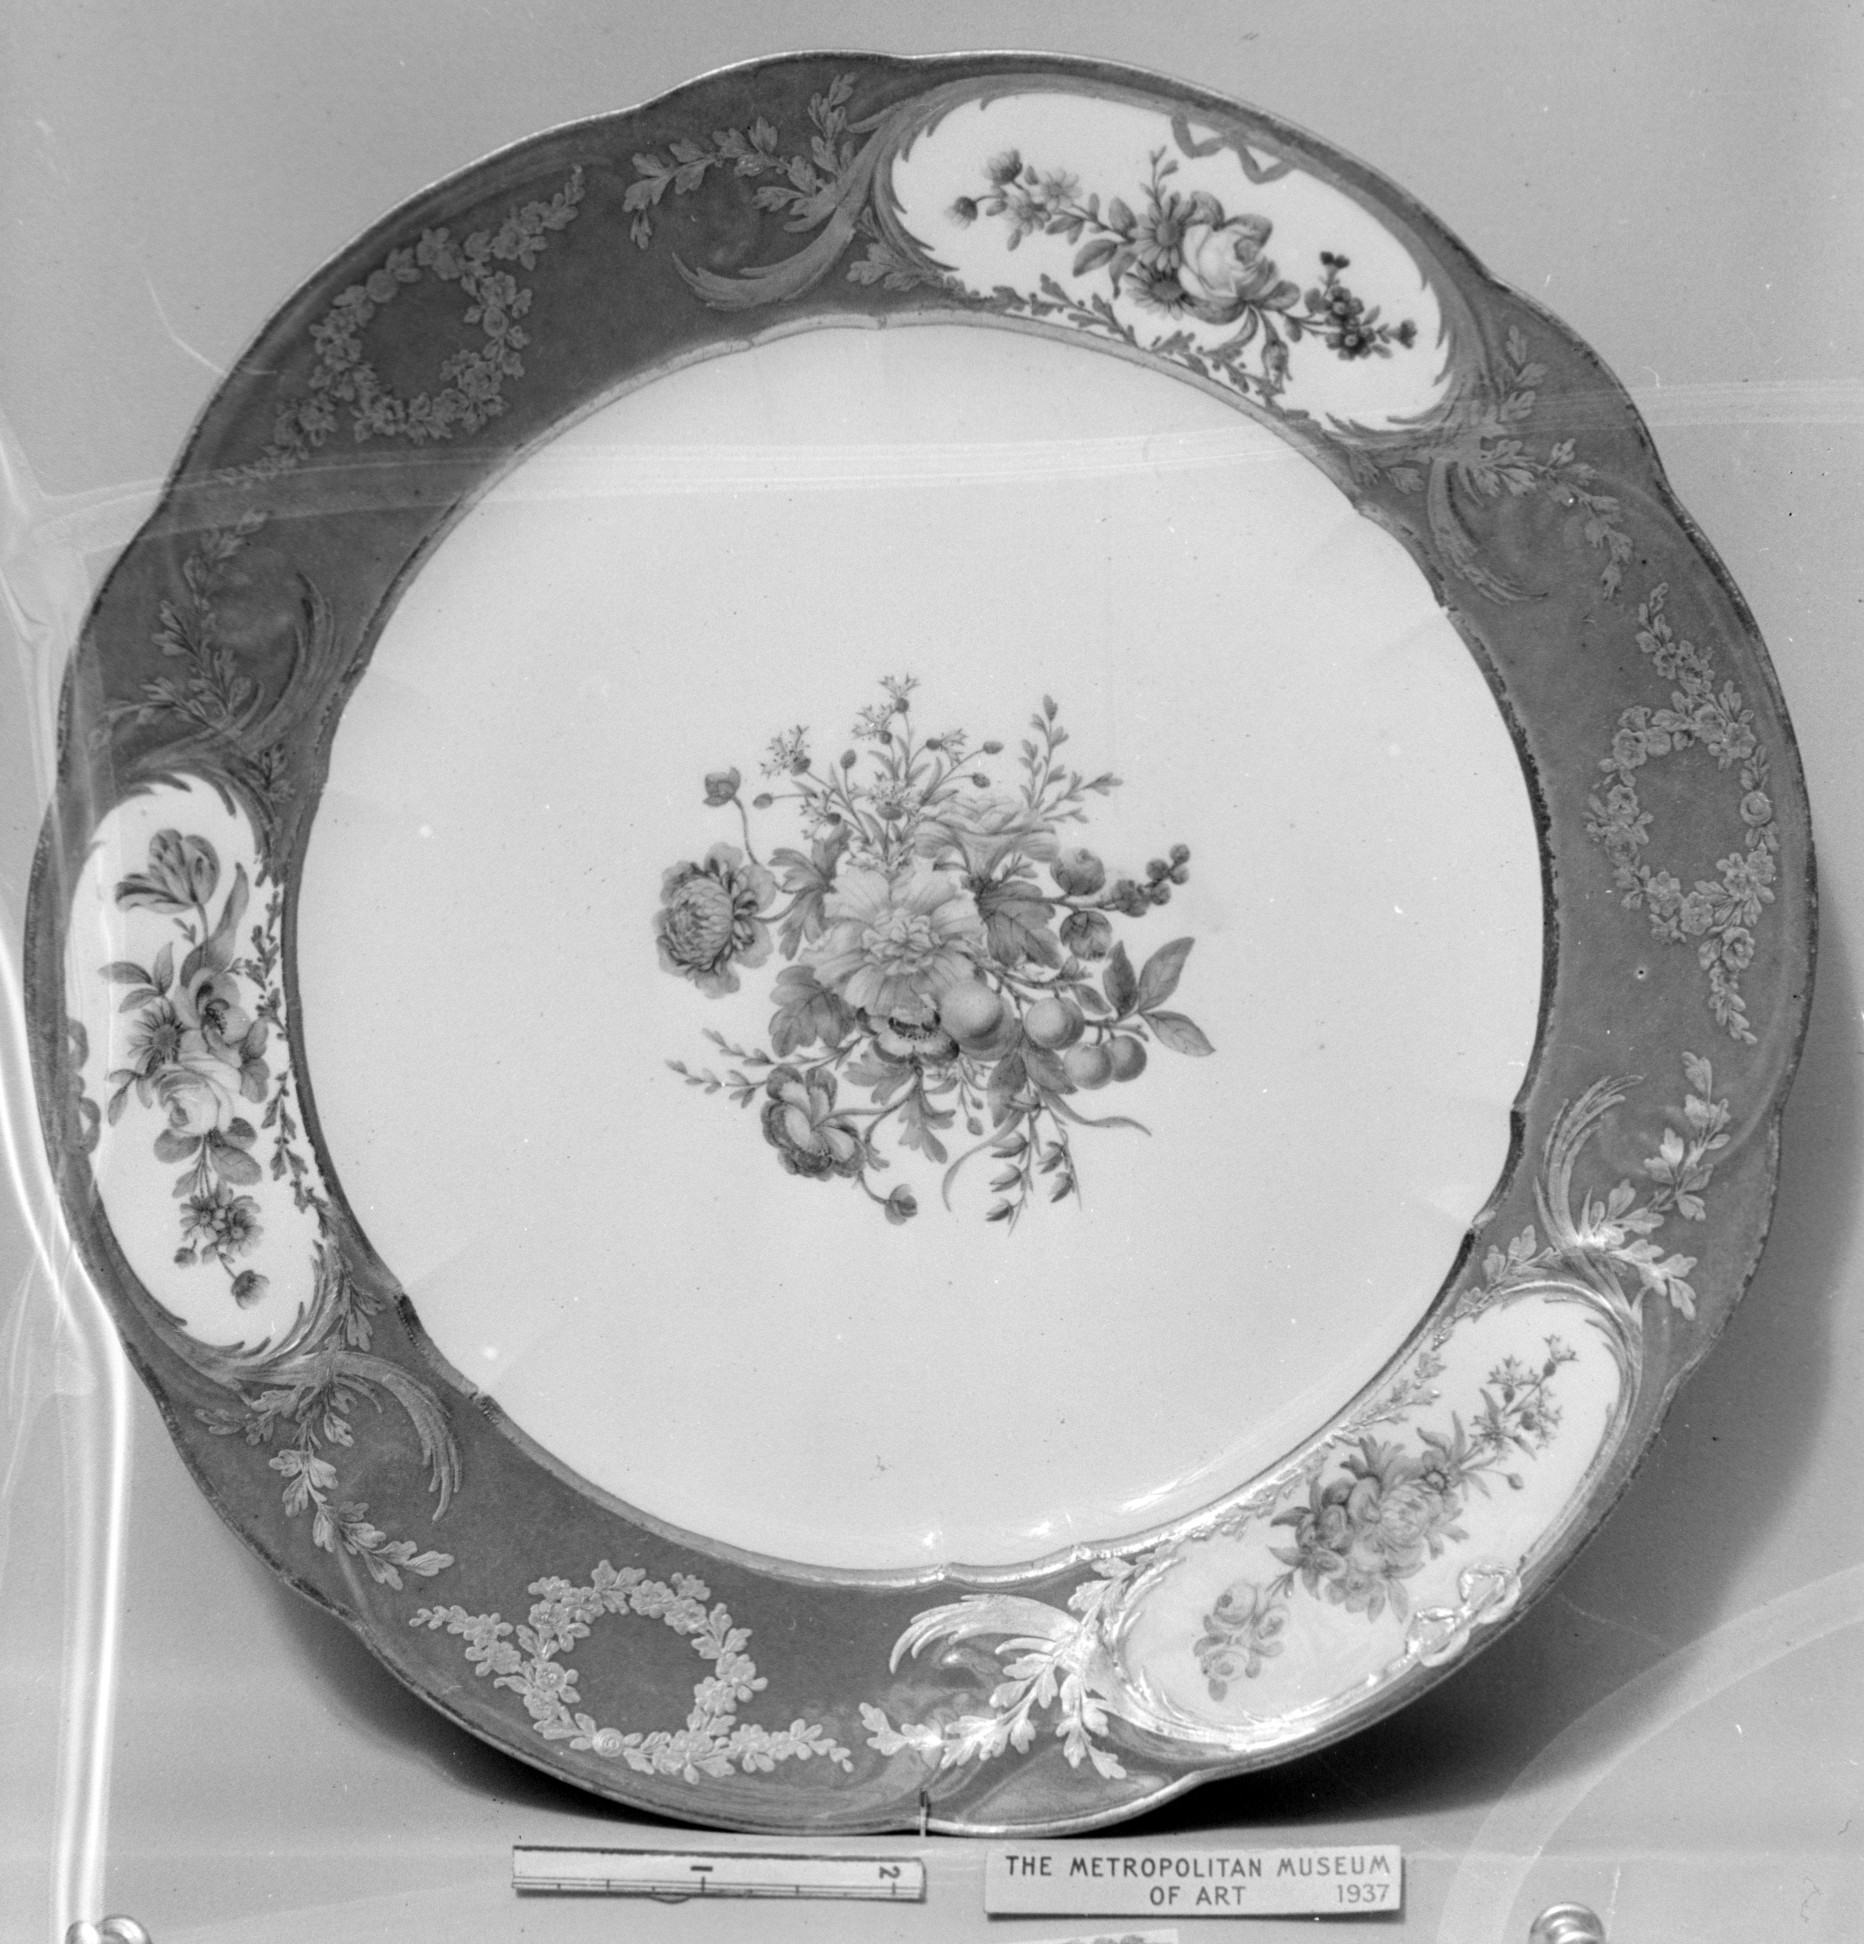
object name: plate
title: Plate (part of a service)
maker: sèvres manufactory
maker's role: manufactory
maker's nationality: french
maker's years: 1740-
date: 1784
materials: soft paste porcelain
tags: garlands,flowers